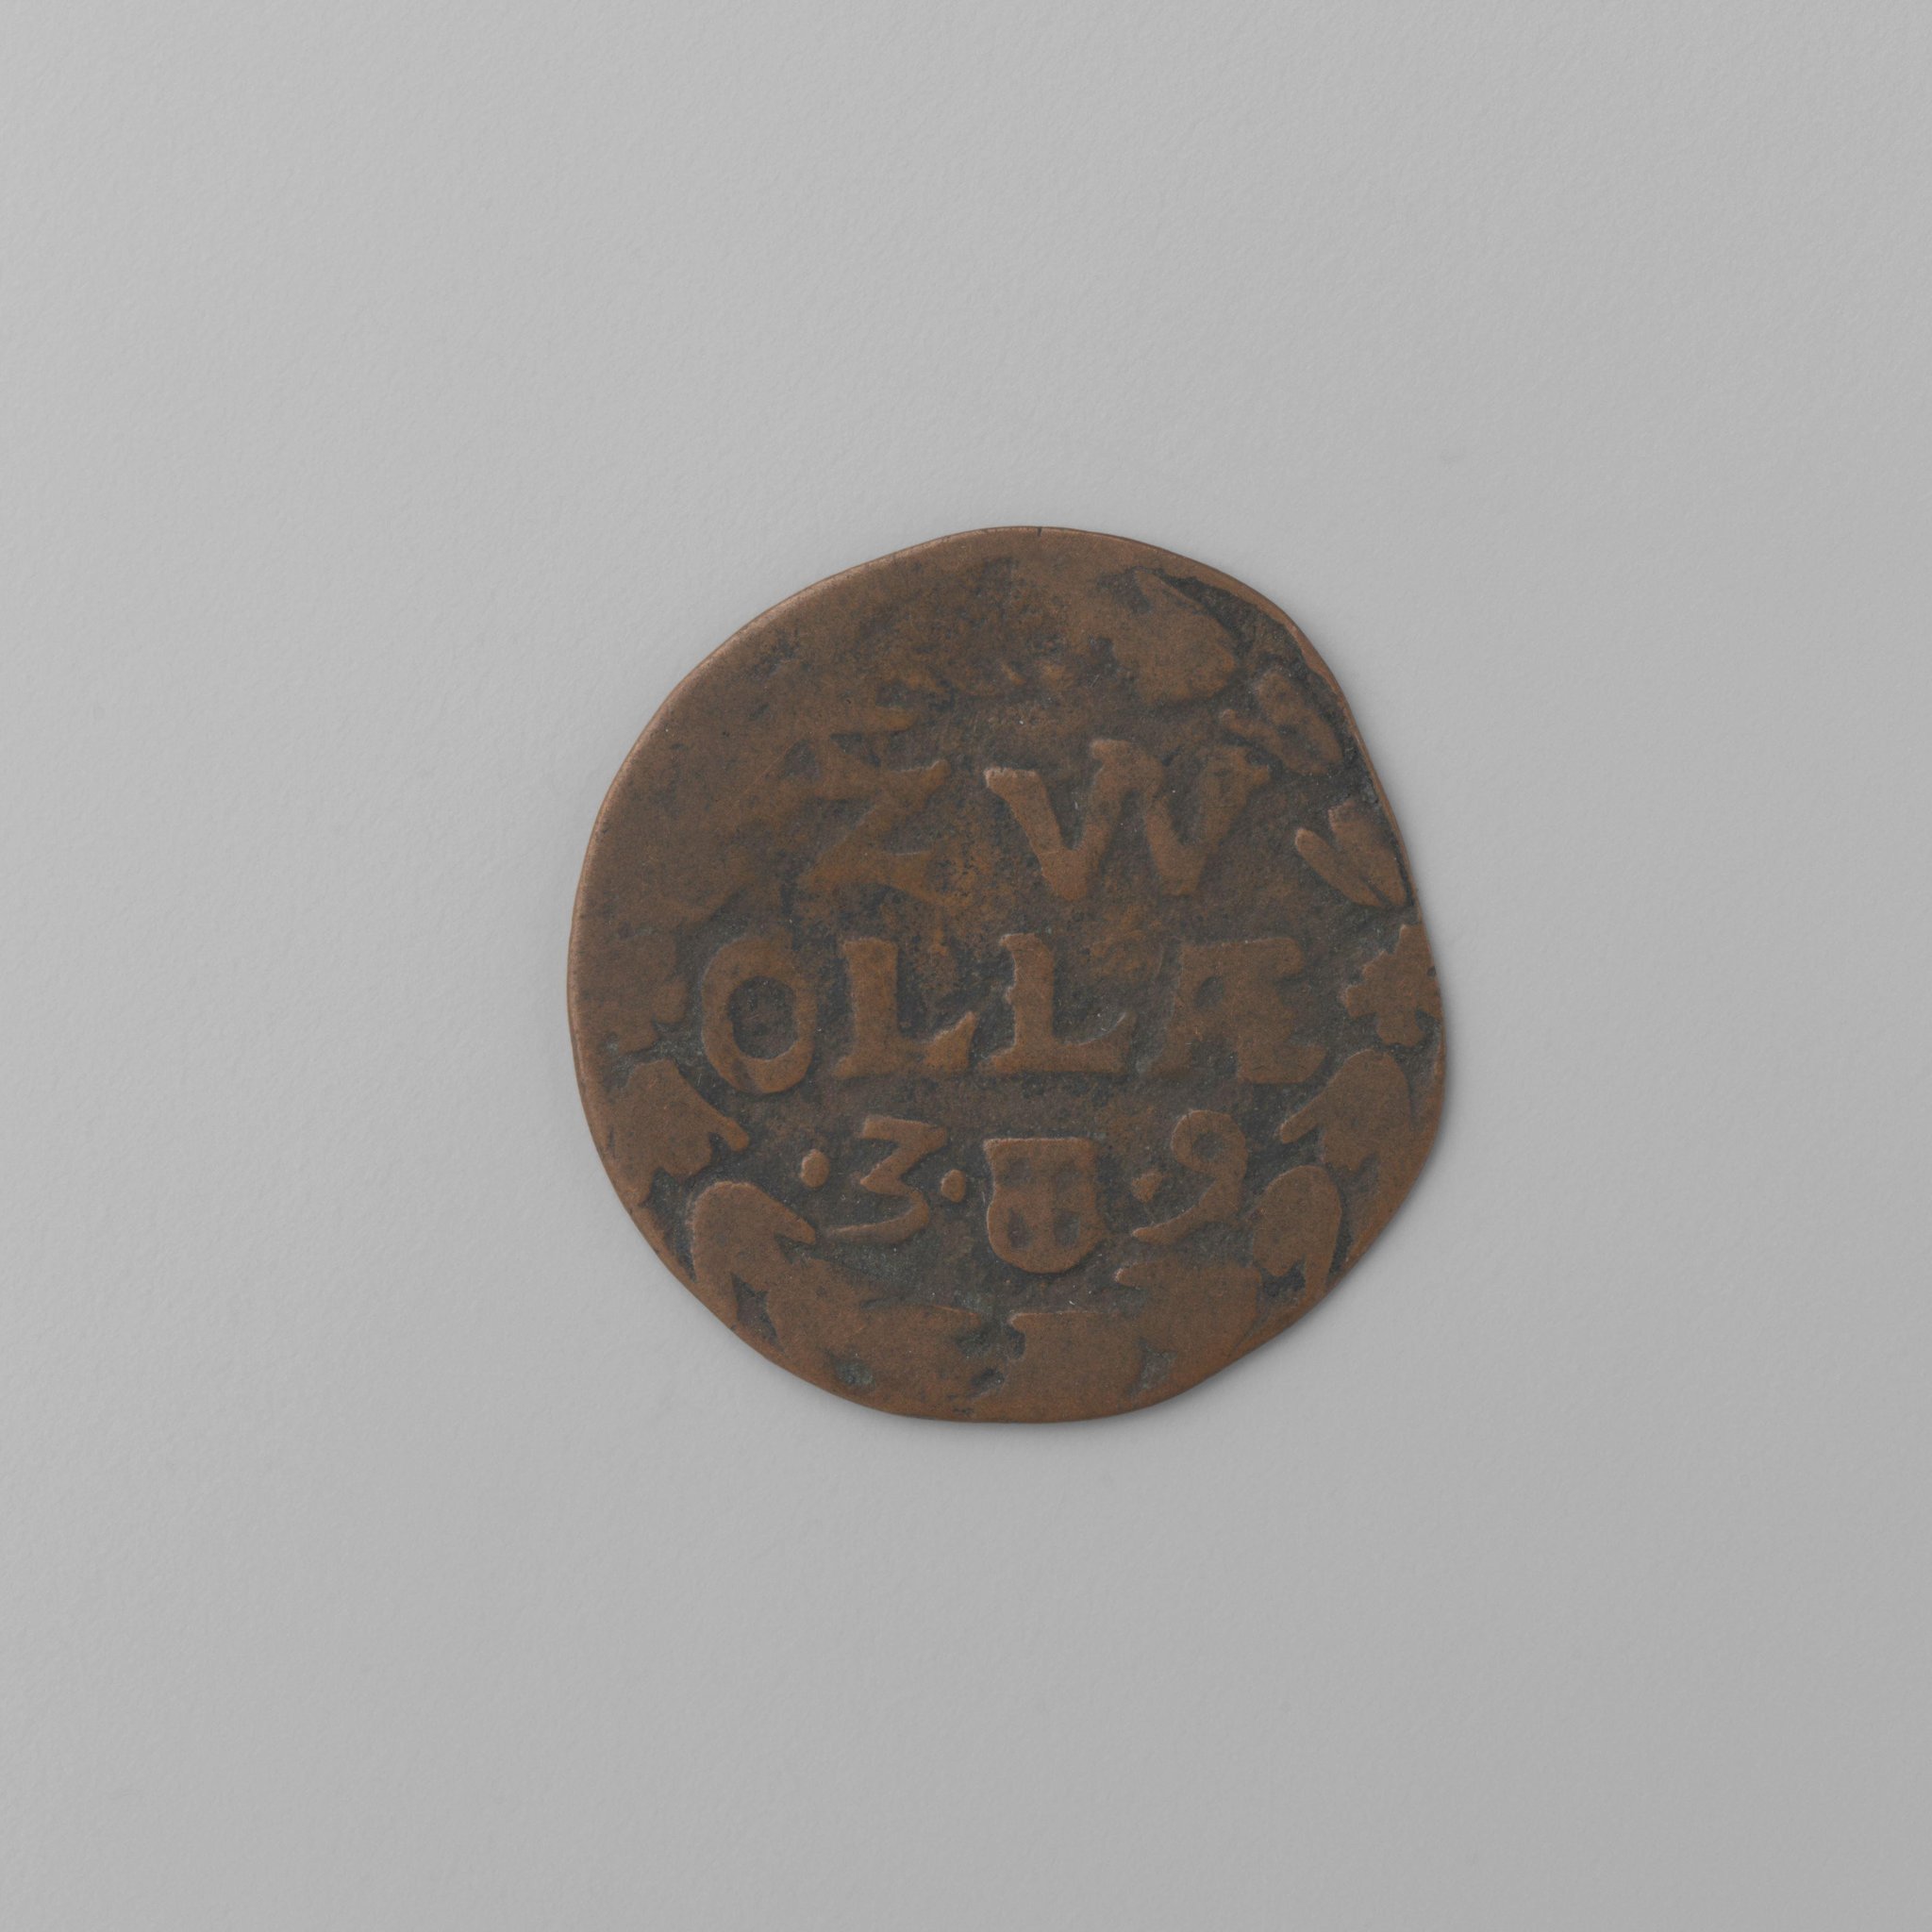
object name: coin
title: Zwolle, duit, 1639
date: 1639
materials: copper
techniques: striking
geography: zwolle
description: Koperen munt. Voorzijde: versierd wapenschild van Zwolle. Keerzijde: binnen krans tweeregelig opschrift, waaronder jaartal 39 tussen wapenschildje.